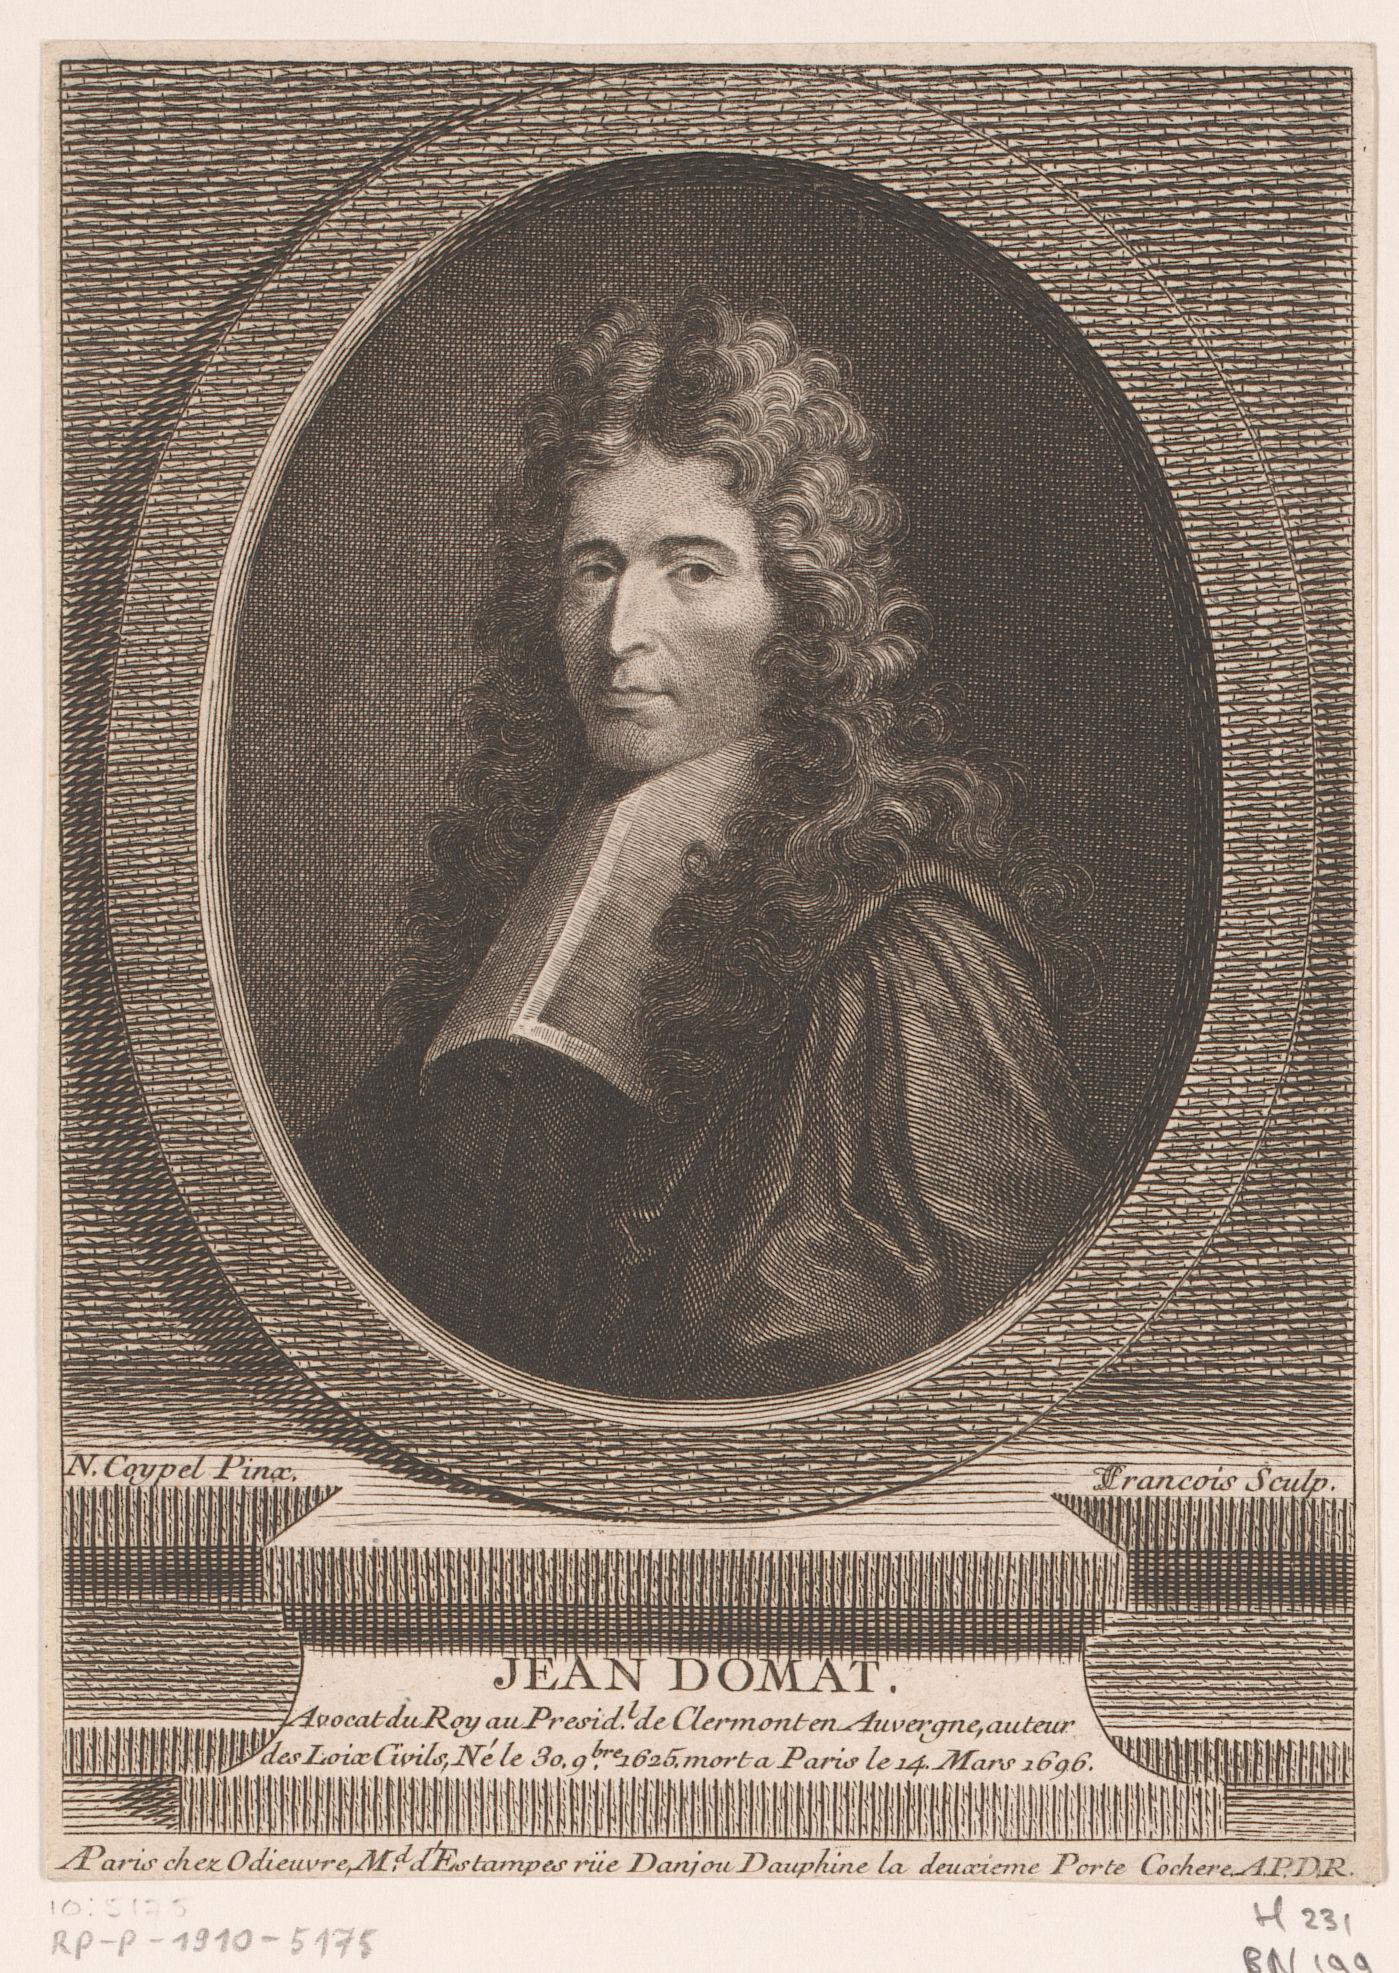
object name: book illustration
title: Portret van Jean Domat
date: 1755-1765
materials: paper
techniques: engraving, etching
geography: france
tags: paris, historical persons, lawyer, attorney at law, portrait of a writer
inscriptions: collector's mark: Lugt 2228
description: Prent uit: Dreux du Radier, Jean-François. L'Europe illustré, contenant l'histoire abregée des souverains, des princes, des prélats, des ministres, (...) en Europe: dans le XVe. siècle compris, jusqu'à présent. Parijs: Michel Odieuvre en Jean-Luc Nyon, 1755-1765.